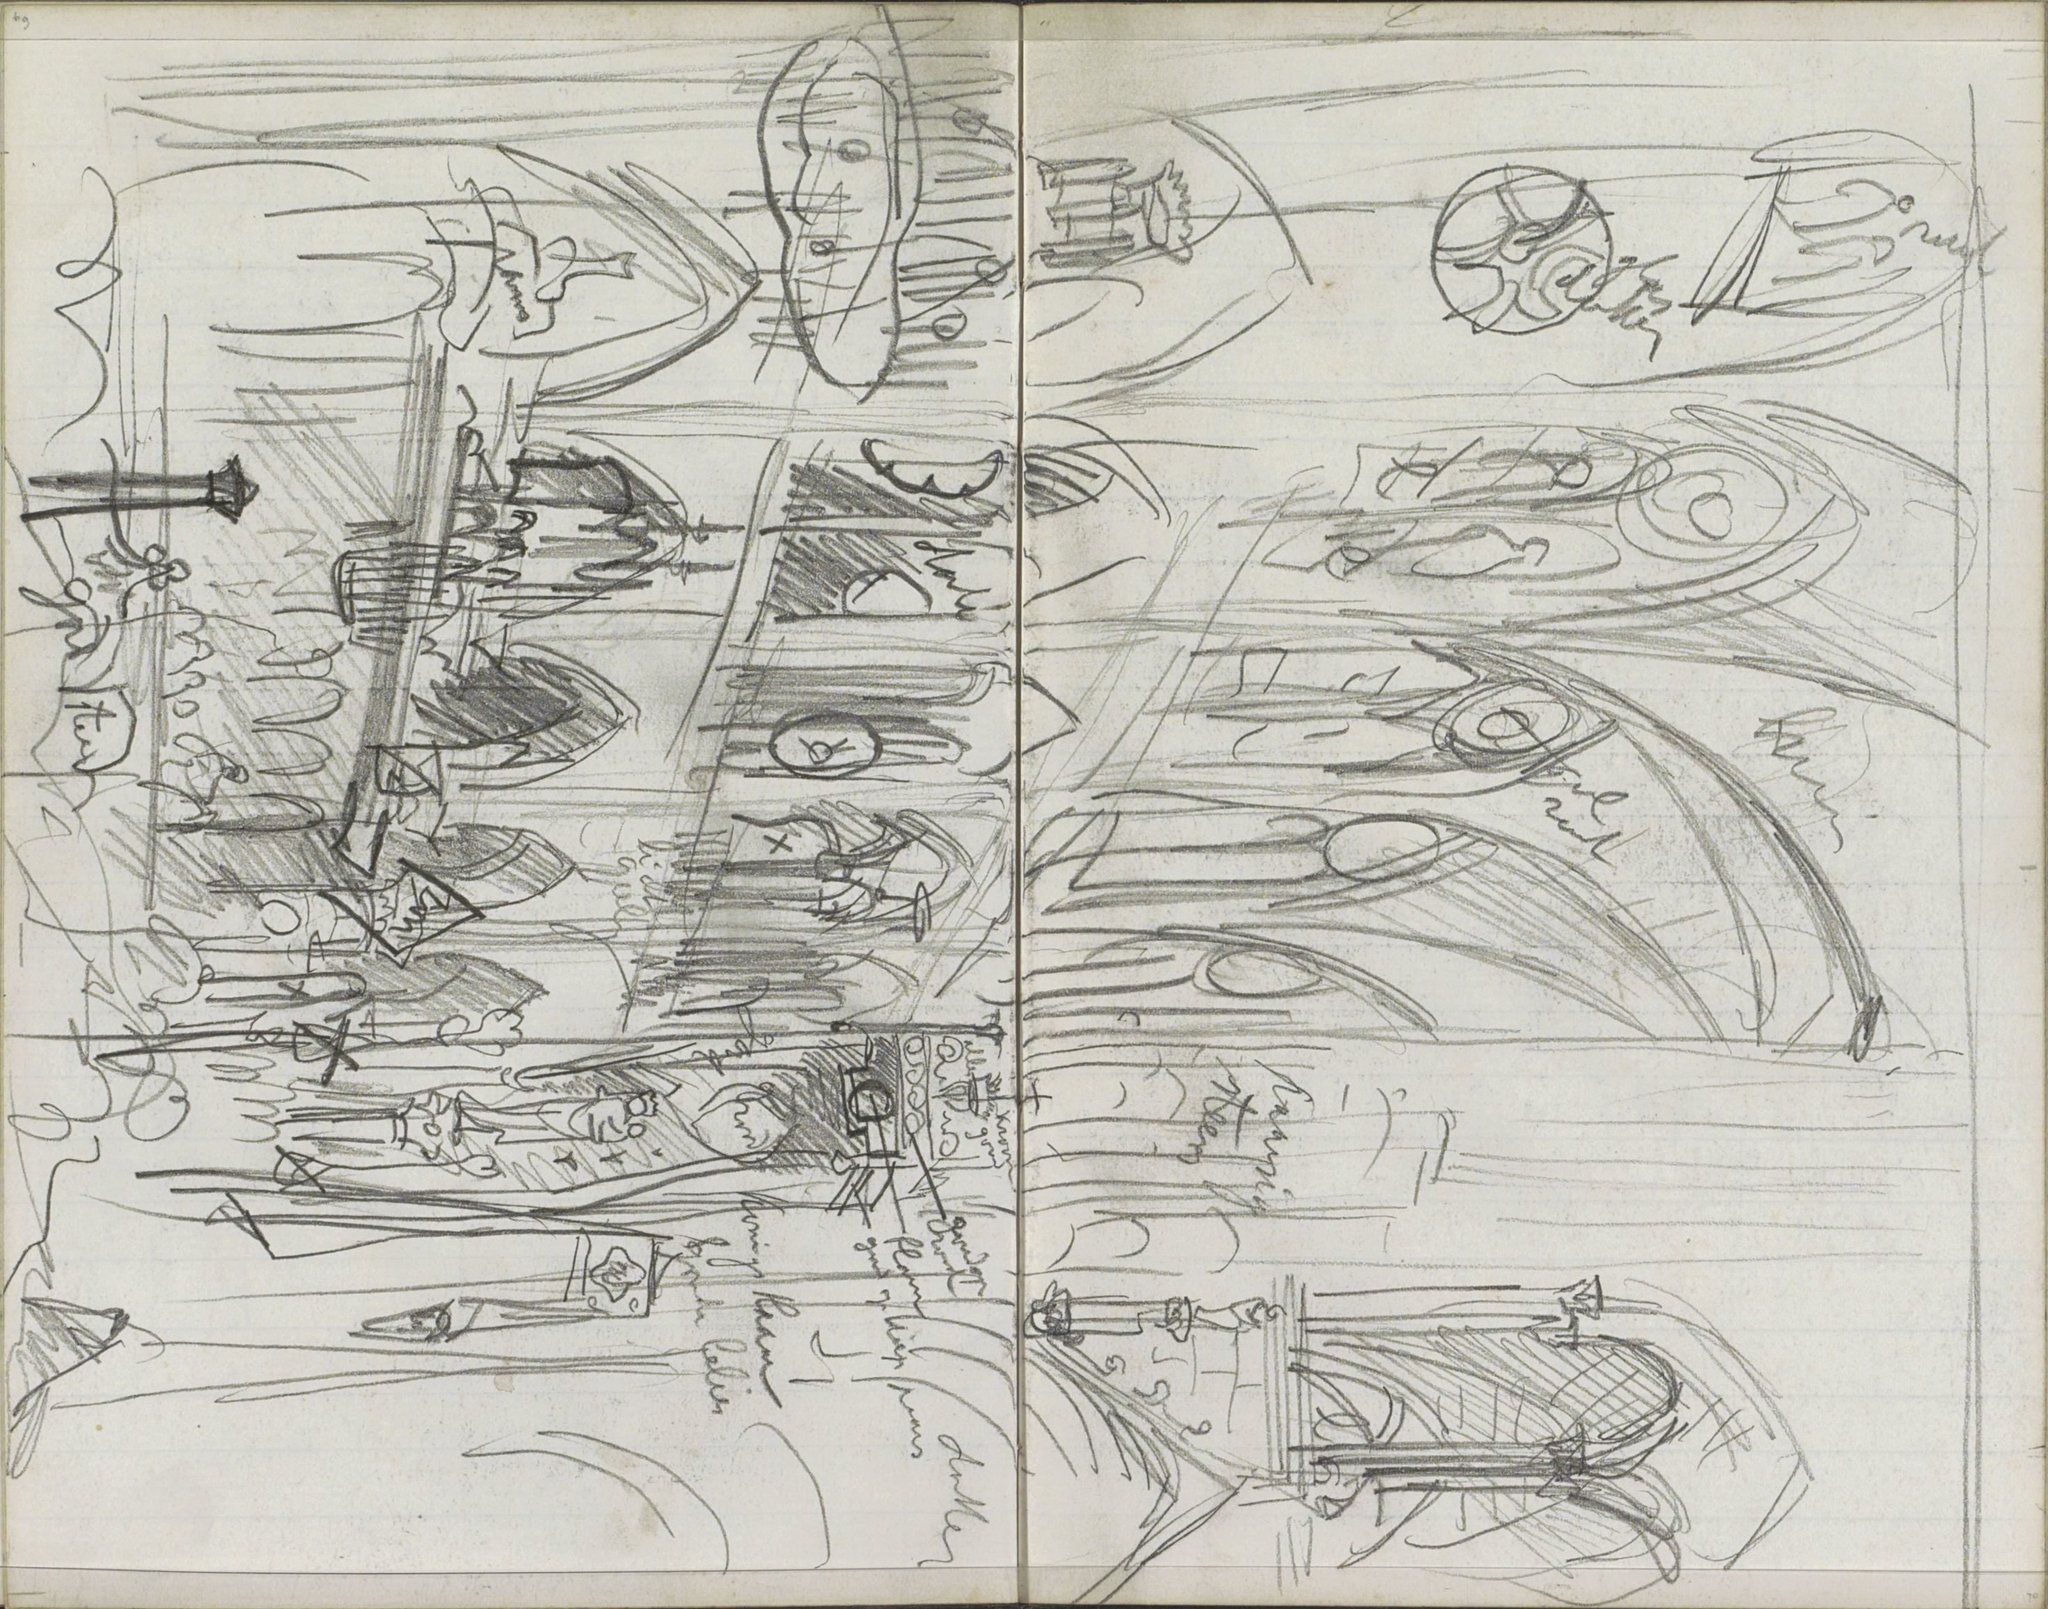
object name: sketchbook leaf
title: Interieur van de Notre-Dame, Parijs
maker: marius bauer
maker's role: draughtsman, print maker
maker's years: 1867-1932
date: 1877-1932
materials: pencil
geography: paris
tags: interior of church, paris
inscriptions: annotation: ‘[...] Konings Raam/ [...] lelies’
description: Pagina 69 en 70 uit een schetsboek met 68 bladen.